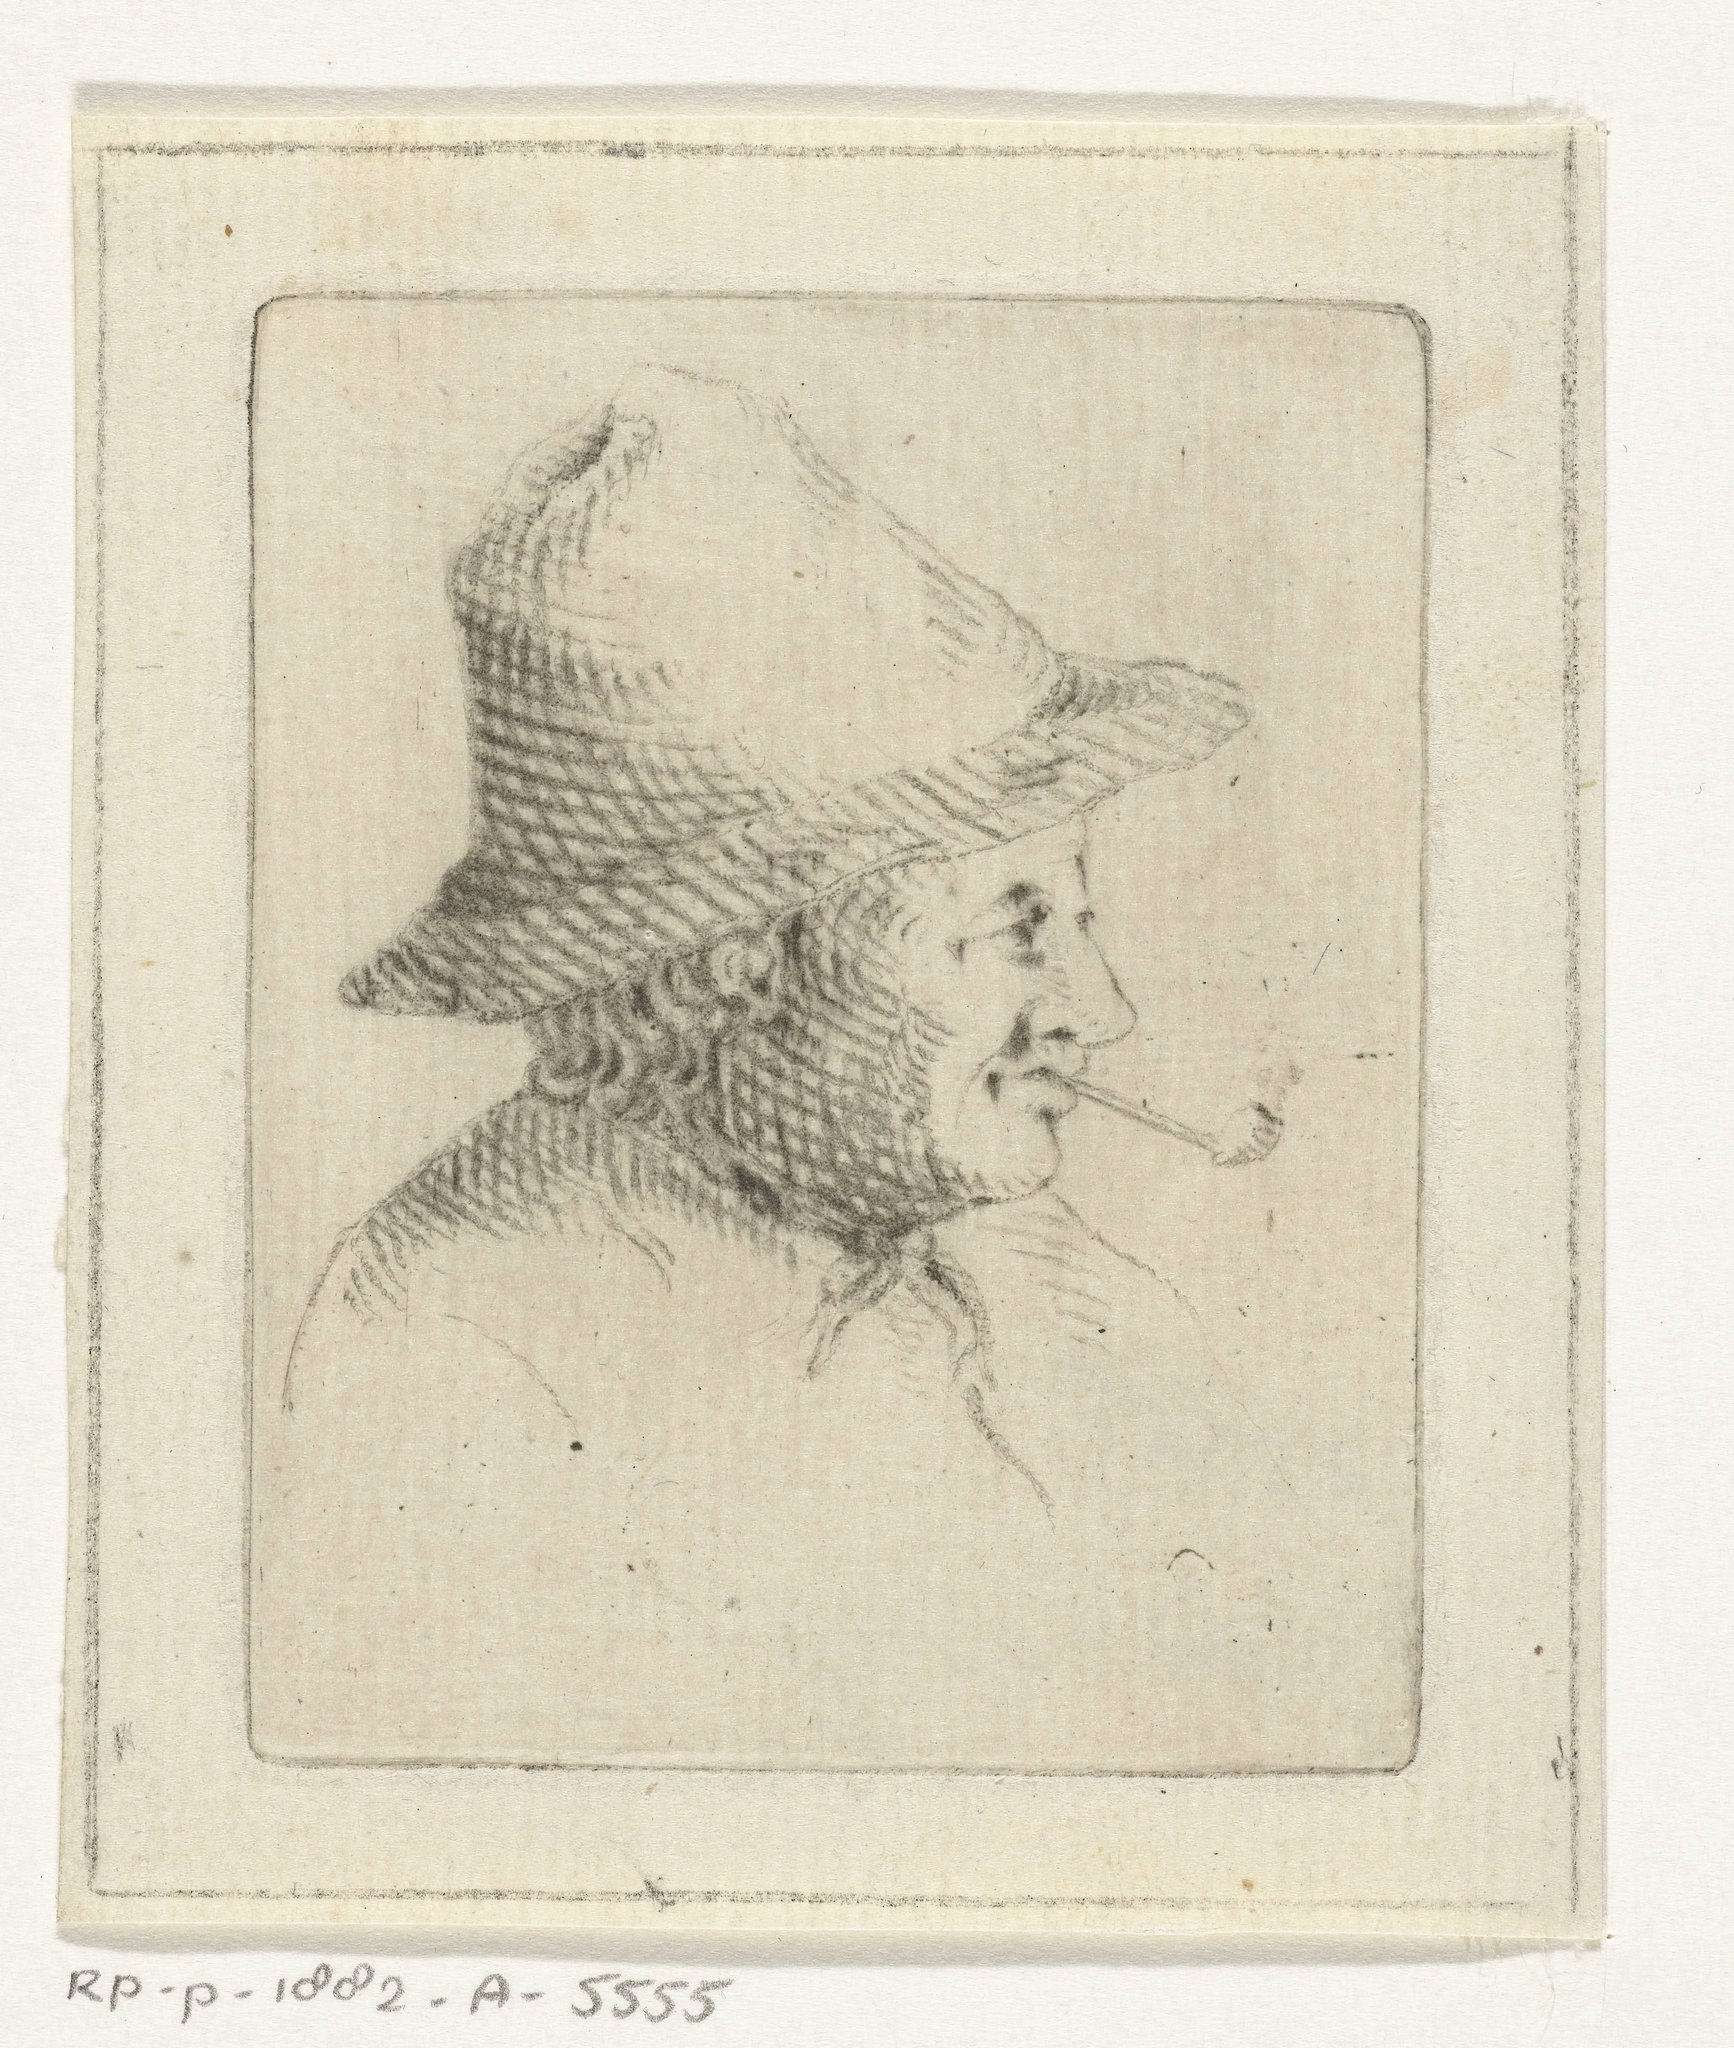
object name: print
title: Borstbeeld van boer met hoed en pijp, en profil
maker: joannis jacobus bijlaert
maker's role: draughtsman, print maker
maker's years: 1734-1809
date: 1749-1809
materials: paper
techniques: printmaking, etching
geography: leiden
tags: pipe ~ tobacco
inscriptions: collector's mark: Lugt 2228